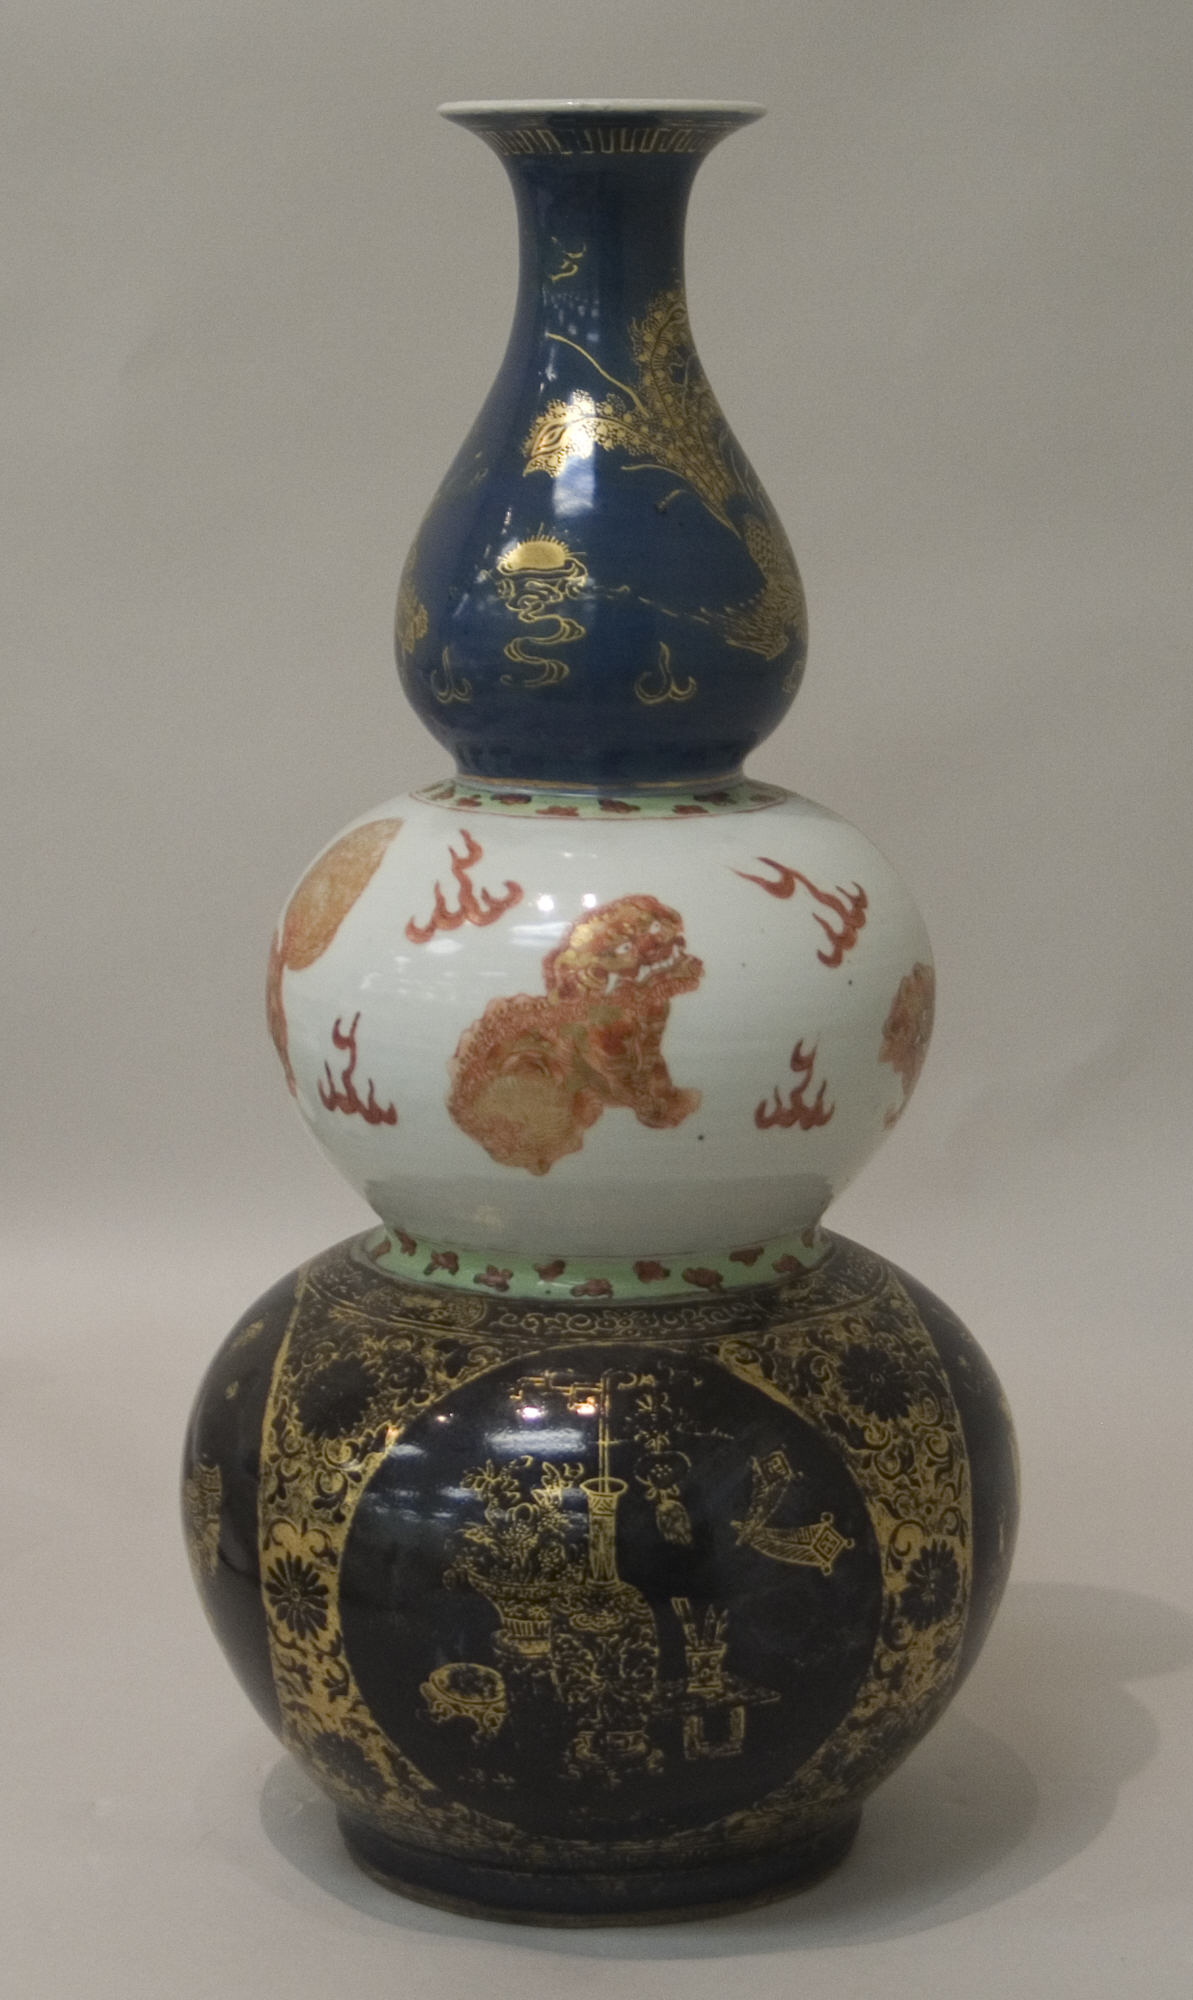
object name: vase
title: Triple gourd vase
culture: chinese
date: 1667-1733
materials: enamel, gilt, porcelain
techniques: overglaze, painting, polychrome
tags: animals,flowers